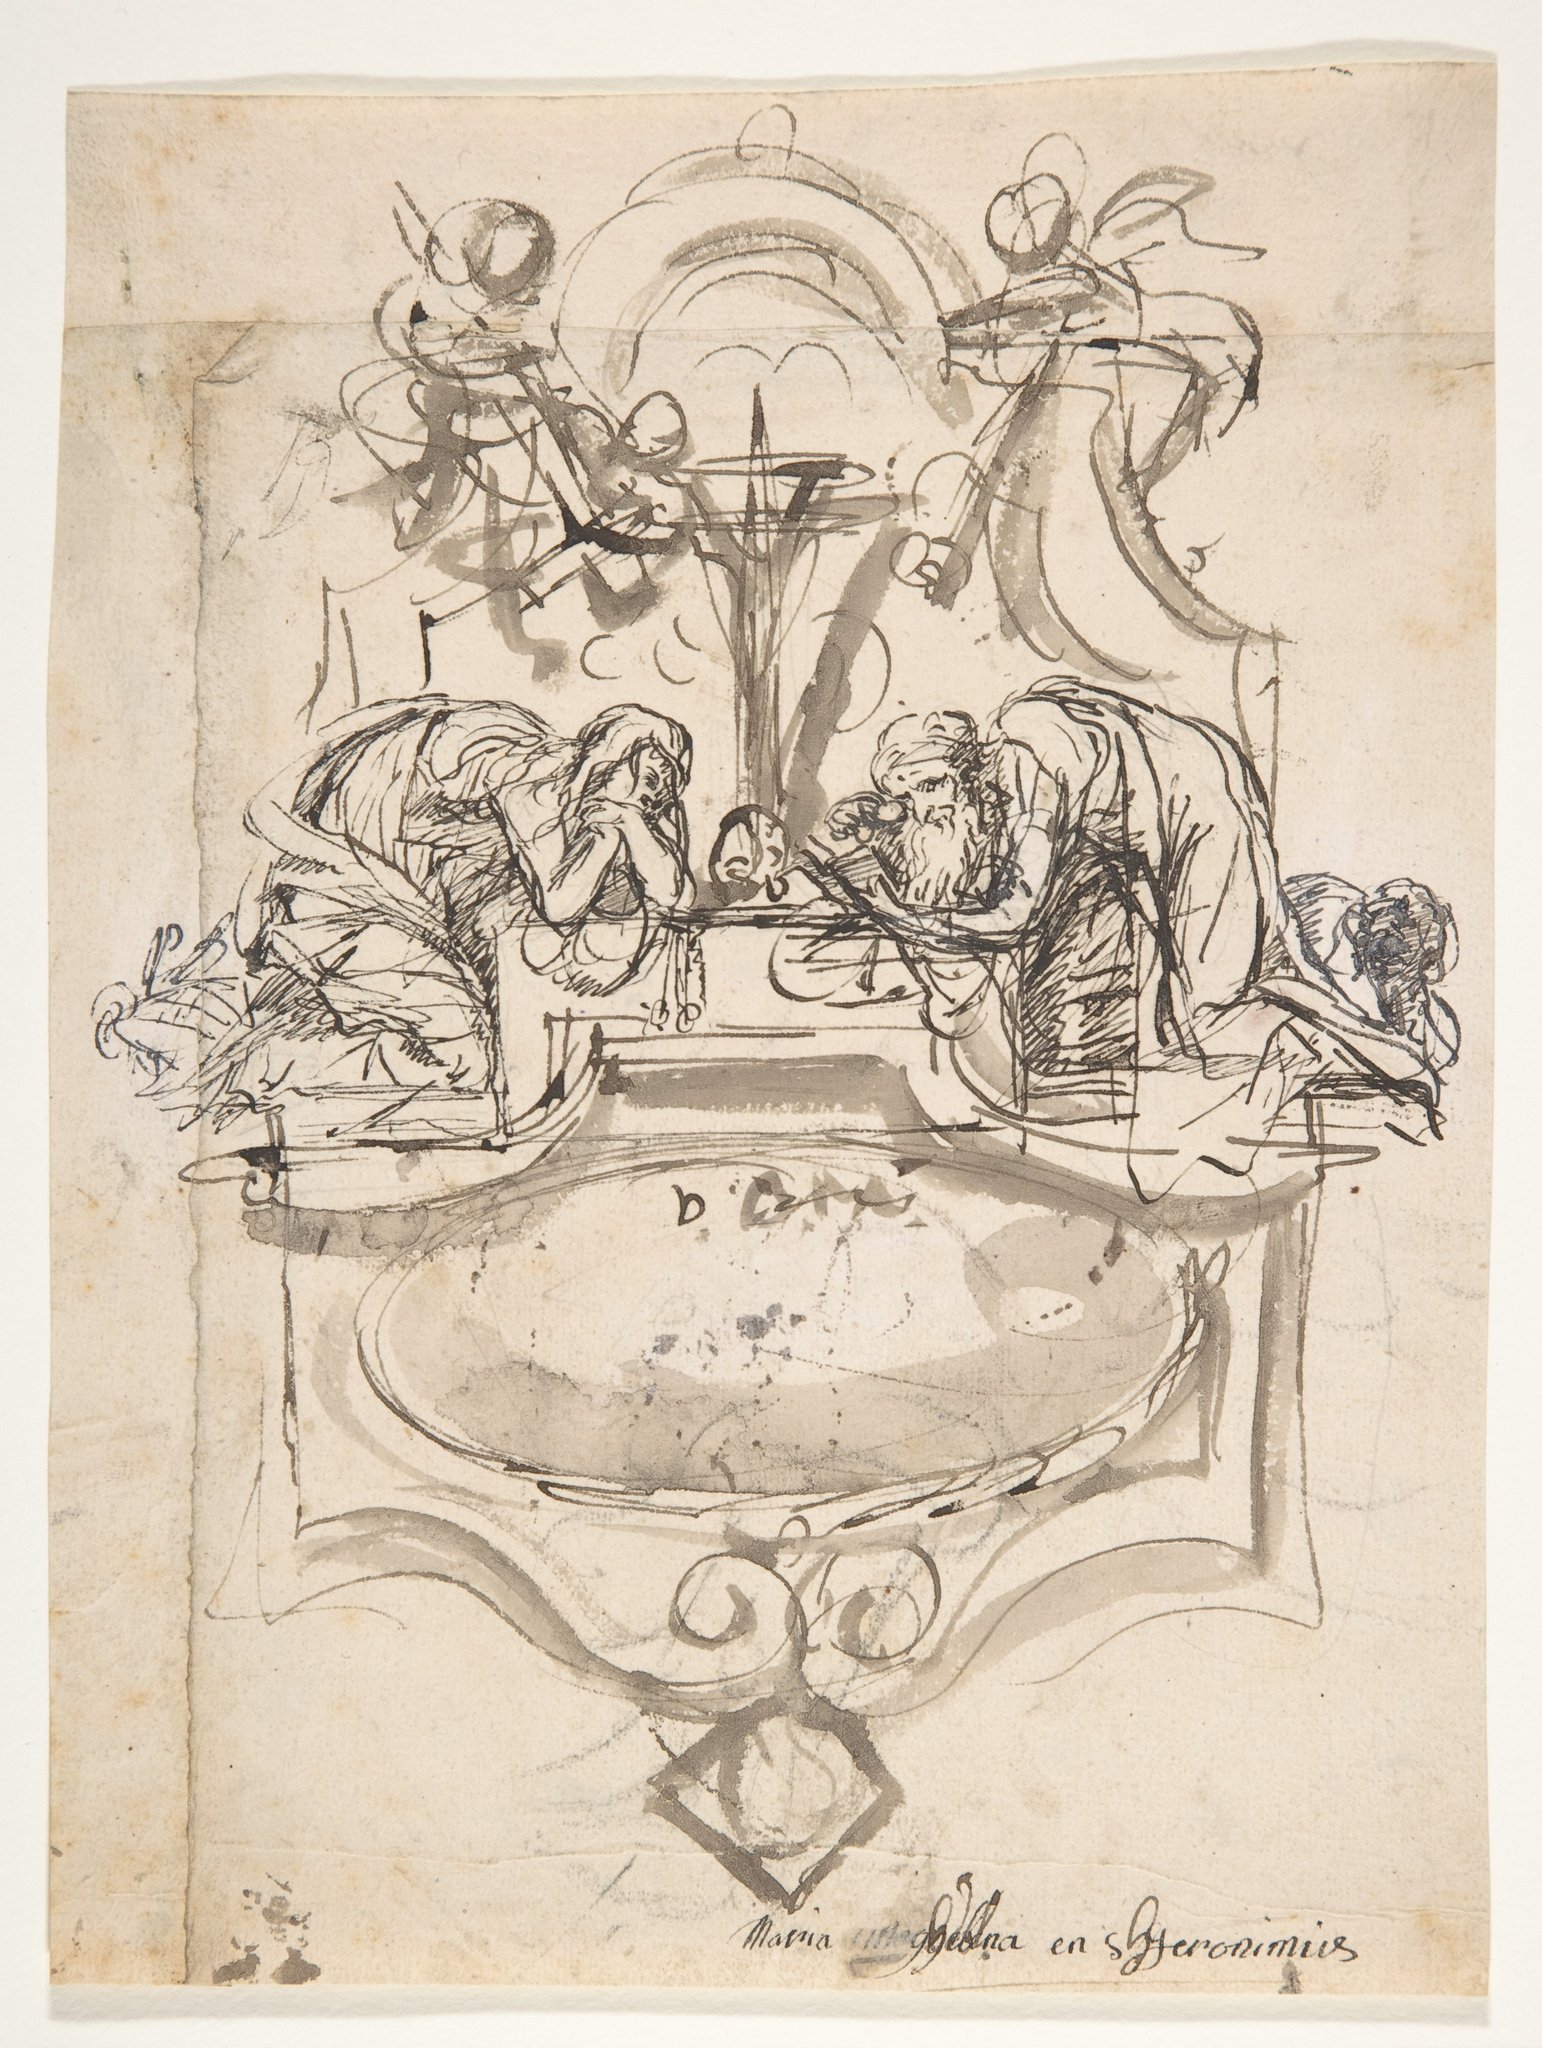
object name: drawing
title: Design for a sepulchral monument with Mary Magdalen and Saint Jerome (recto); Sketch (counterproof) and writing exercises (verso)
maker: pieter verbruggen the younger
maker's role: artist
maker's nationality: flemish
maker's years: 1648-1691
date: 1667-1733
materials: chalk, ink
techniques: printmaking, drawing, pen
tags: architecture,mary magdalene,saint jerome